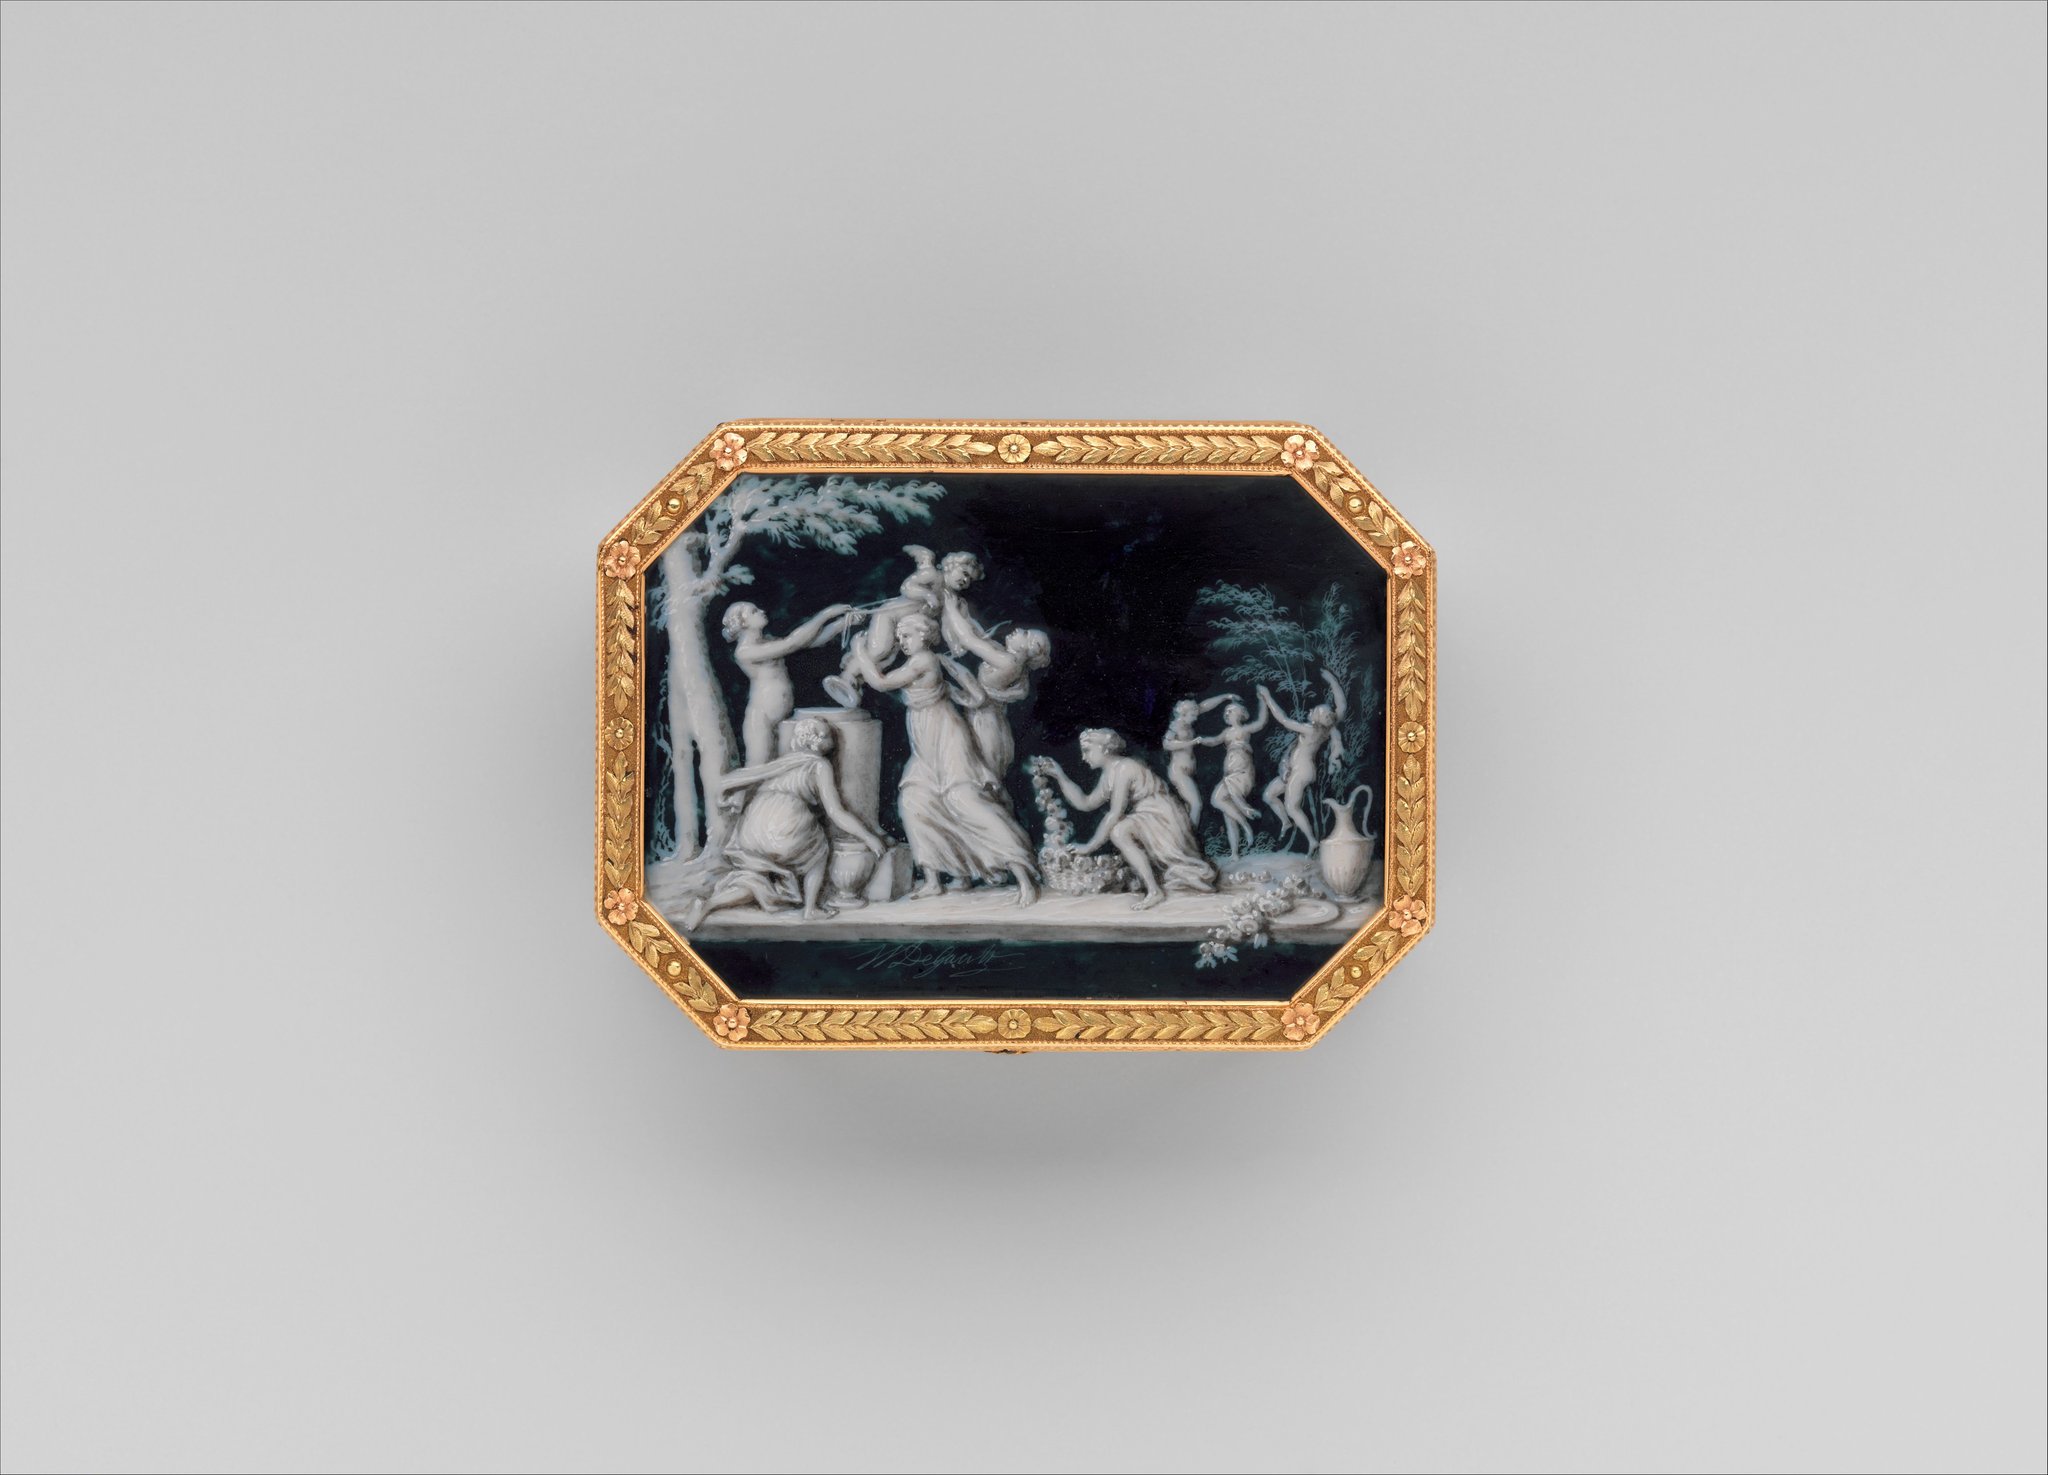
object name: snuffbox, painting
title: Snuffbox with miniatures representing the Diversions of Love and dancing figure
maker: jacques joseph de gault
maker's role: artist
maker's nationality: french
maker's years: 1738-1812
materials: enamel, gold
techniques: grisaille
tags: women,dancing,cupid,trees